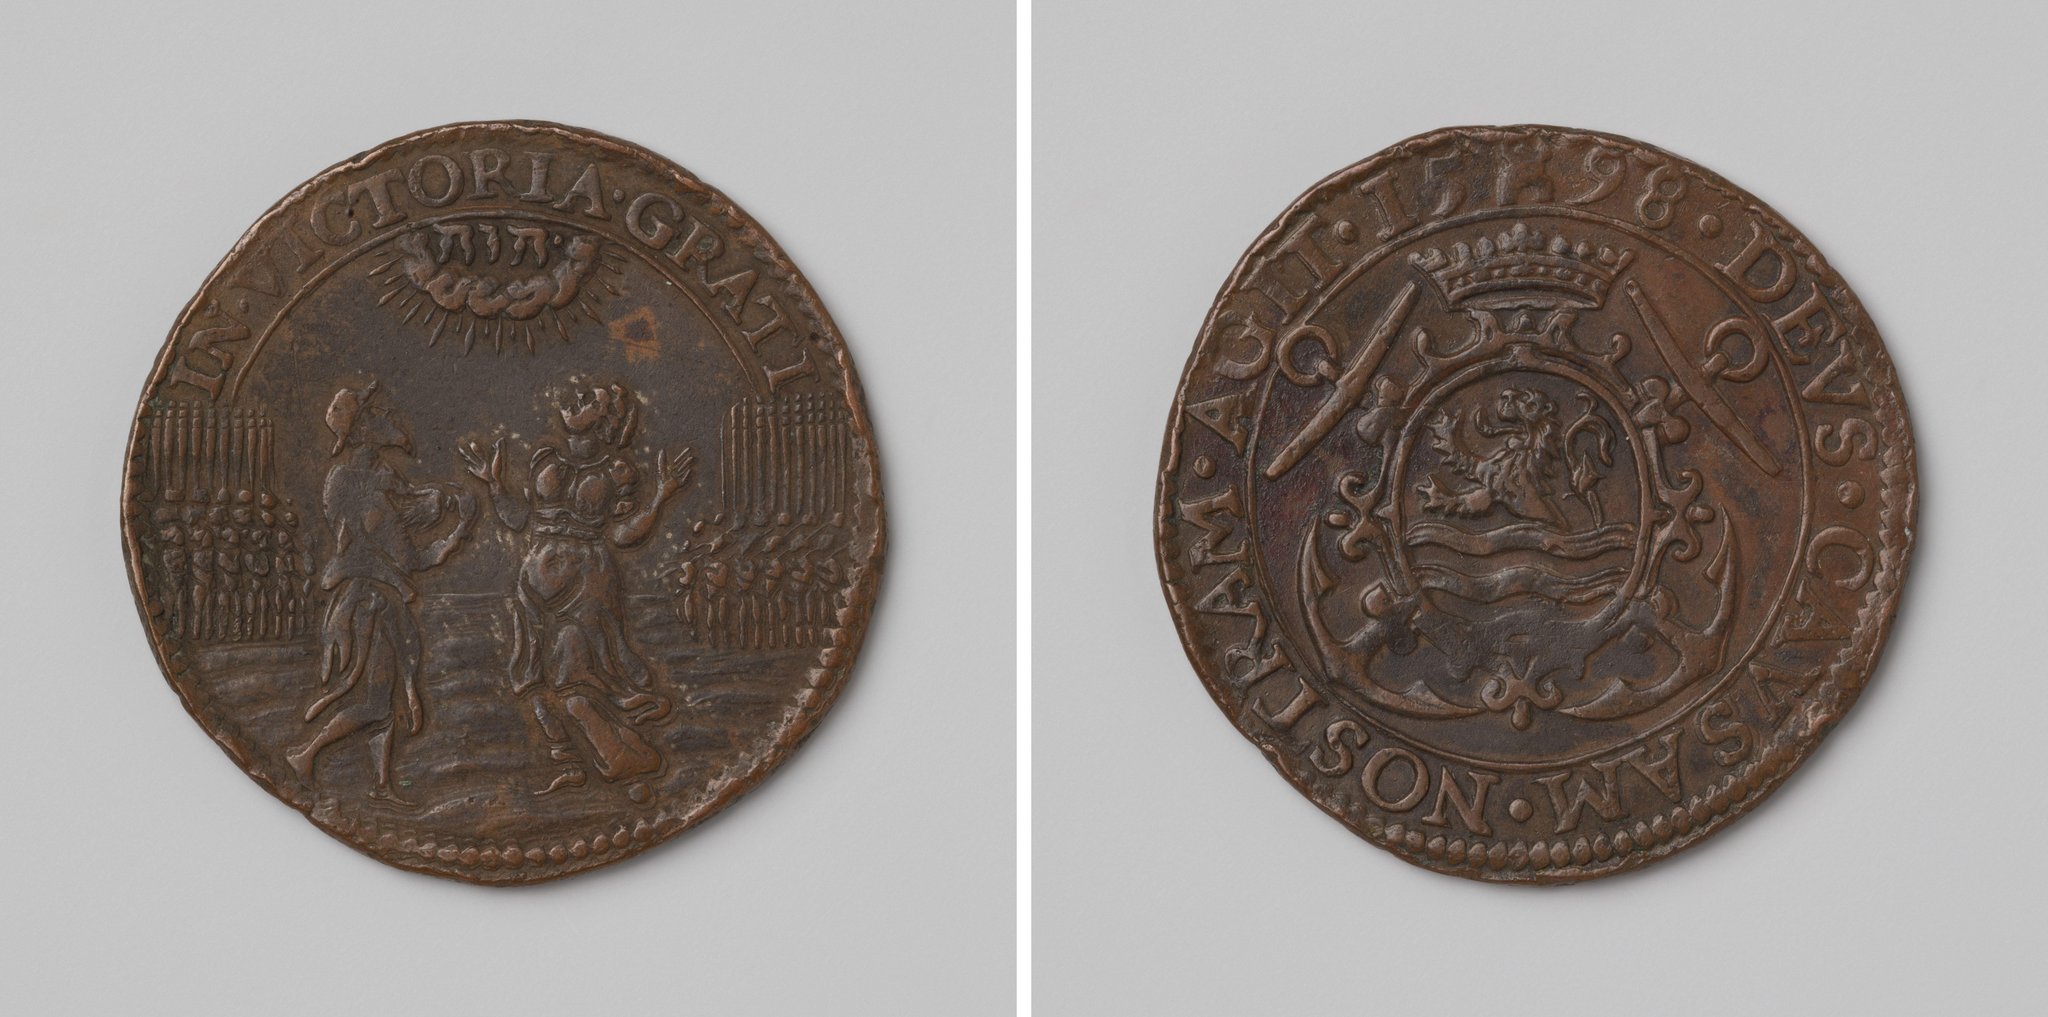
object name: jeton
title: Algemene dank-, vast- en biddag uitgeroepen door de Staten-Generaal ter viering van de aftocht van de Spaanse troepen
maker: Anonymous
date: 1598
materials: copper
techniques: striking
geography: middelburg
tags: zeeland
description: Penning geslagen op last van de admiraliteit van Zeeland.